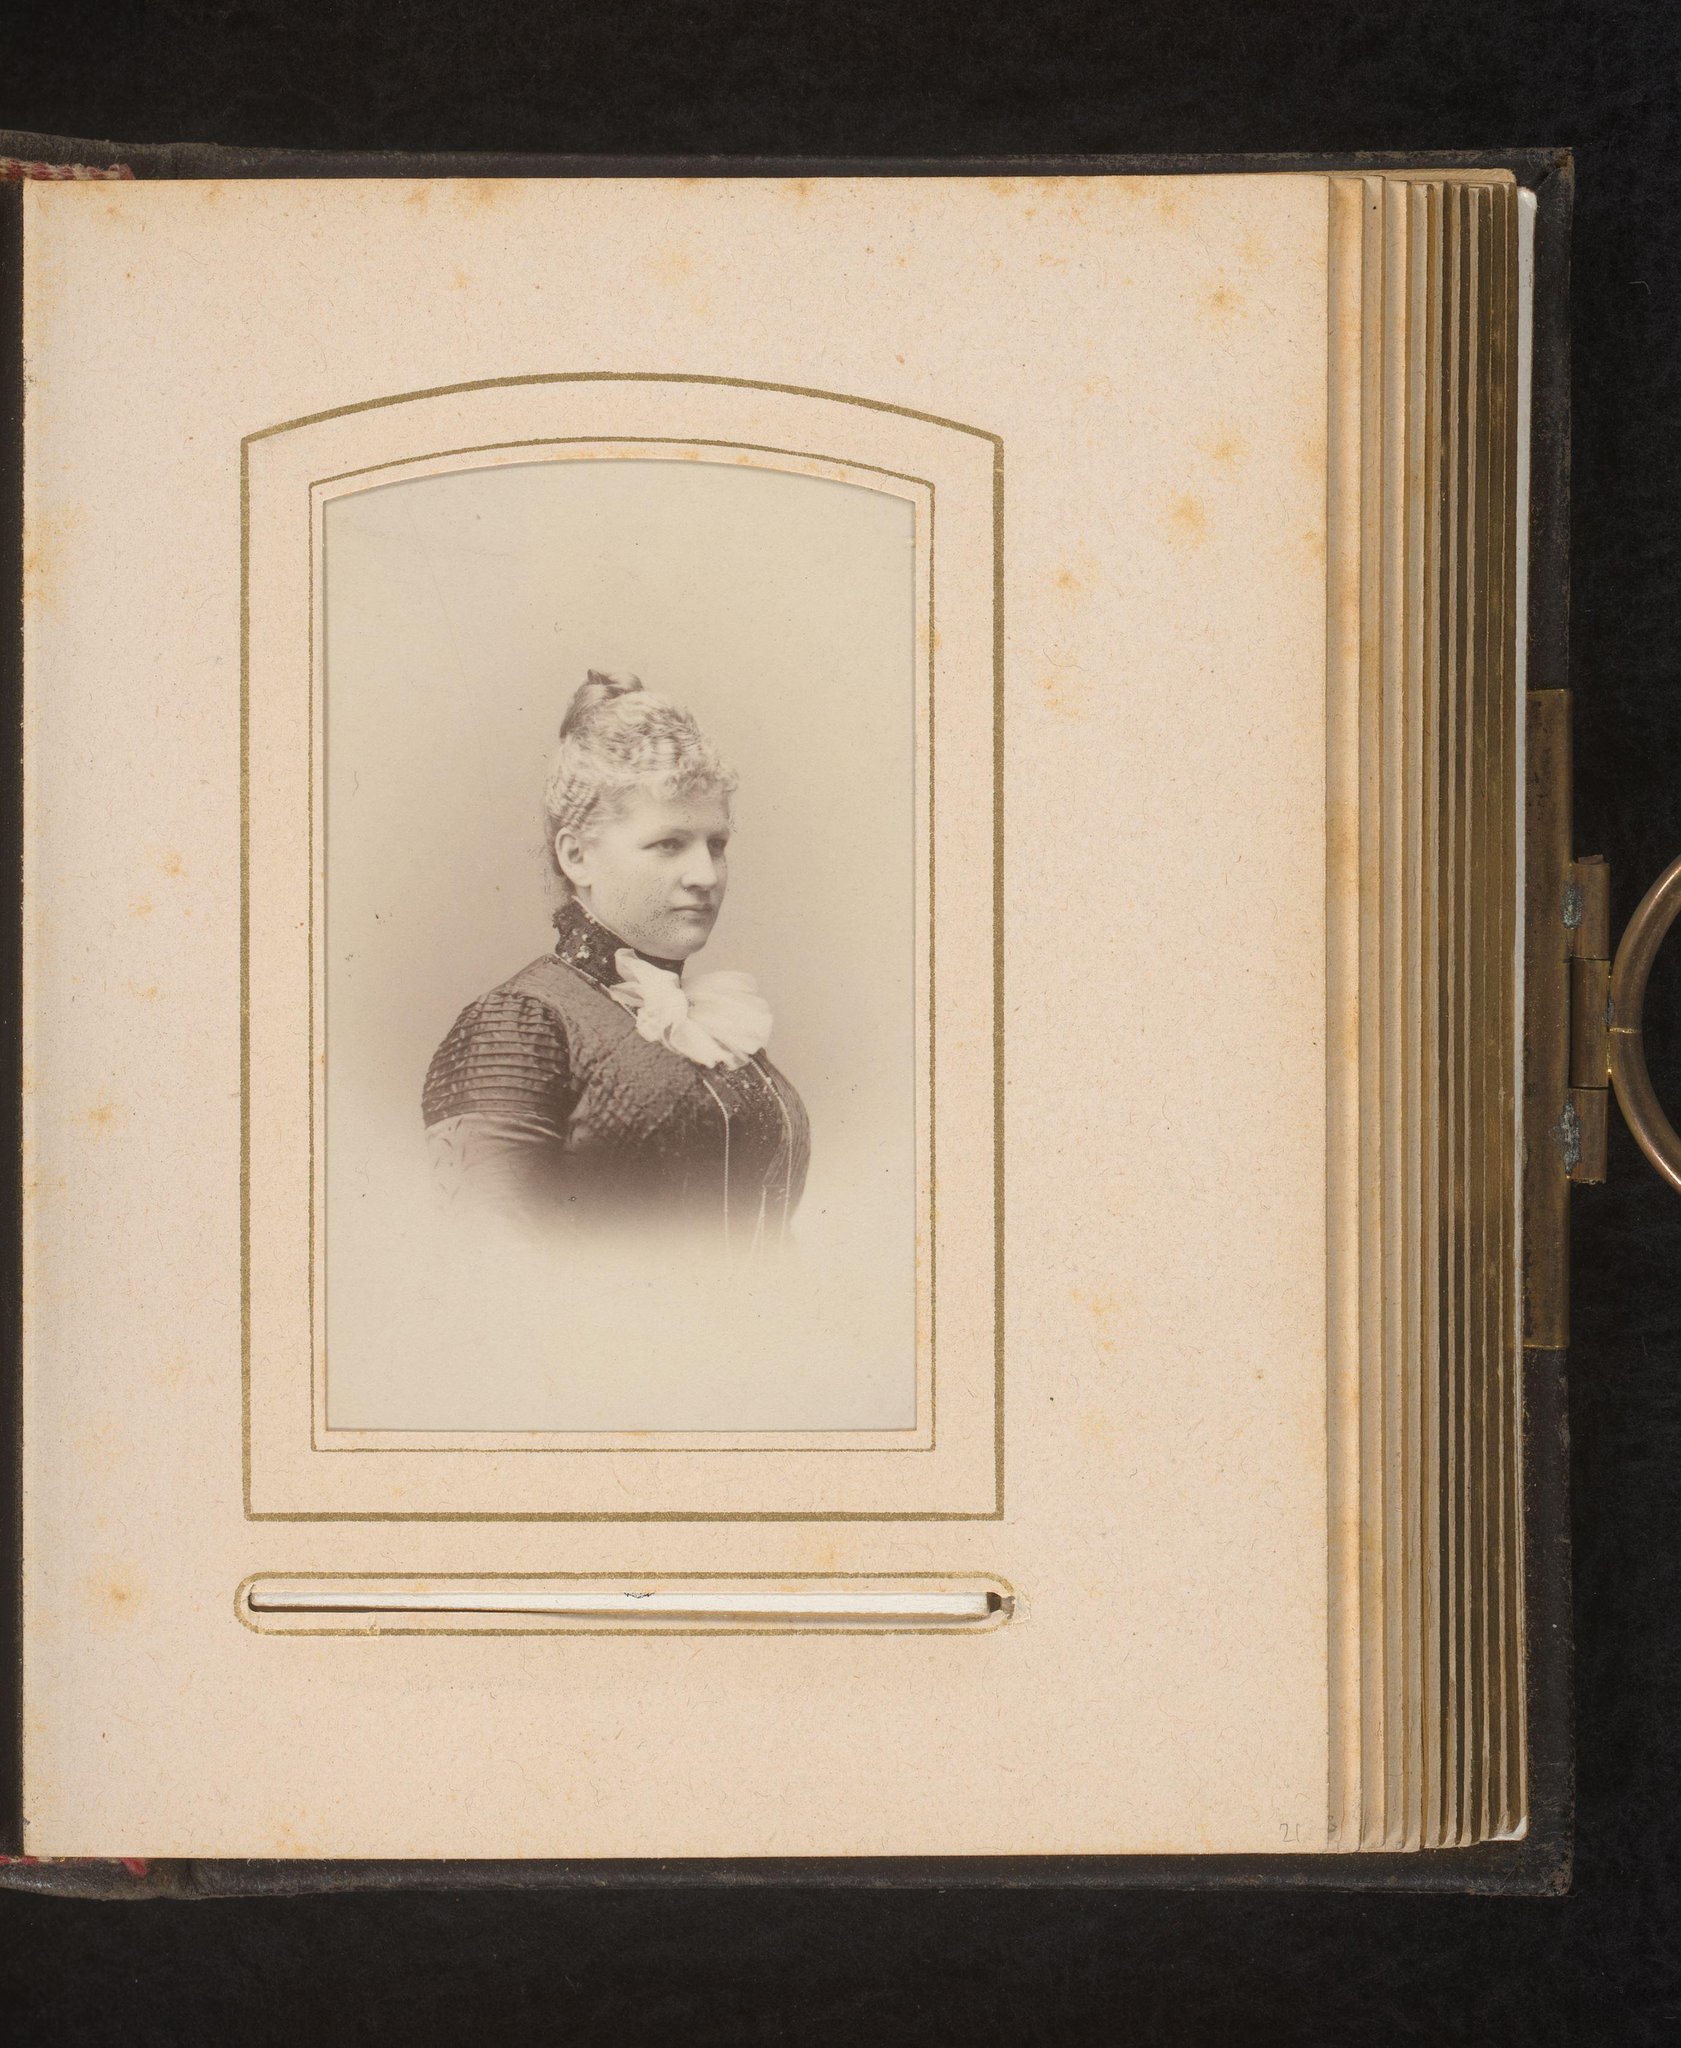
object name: photograph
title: Portret van een vrouw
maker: hans rupprecht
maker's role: fotograaf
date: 1860-1900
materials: cardboard, photographic support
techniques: albumen print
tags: adult woman, historical persons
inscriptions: inscription: ‘(...)/ Hans Rupprecht/ Bremen/ Osterhorsteinweg 49/ vis à vis der Mozartstrasse. (...)’